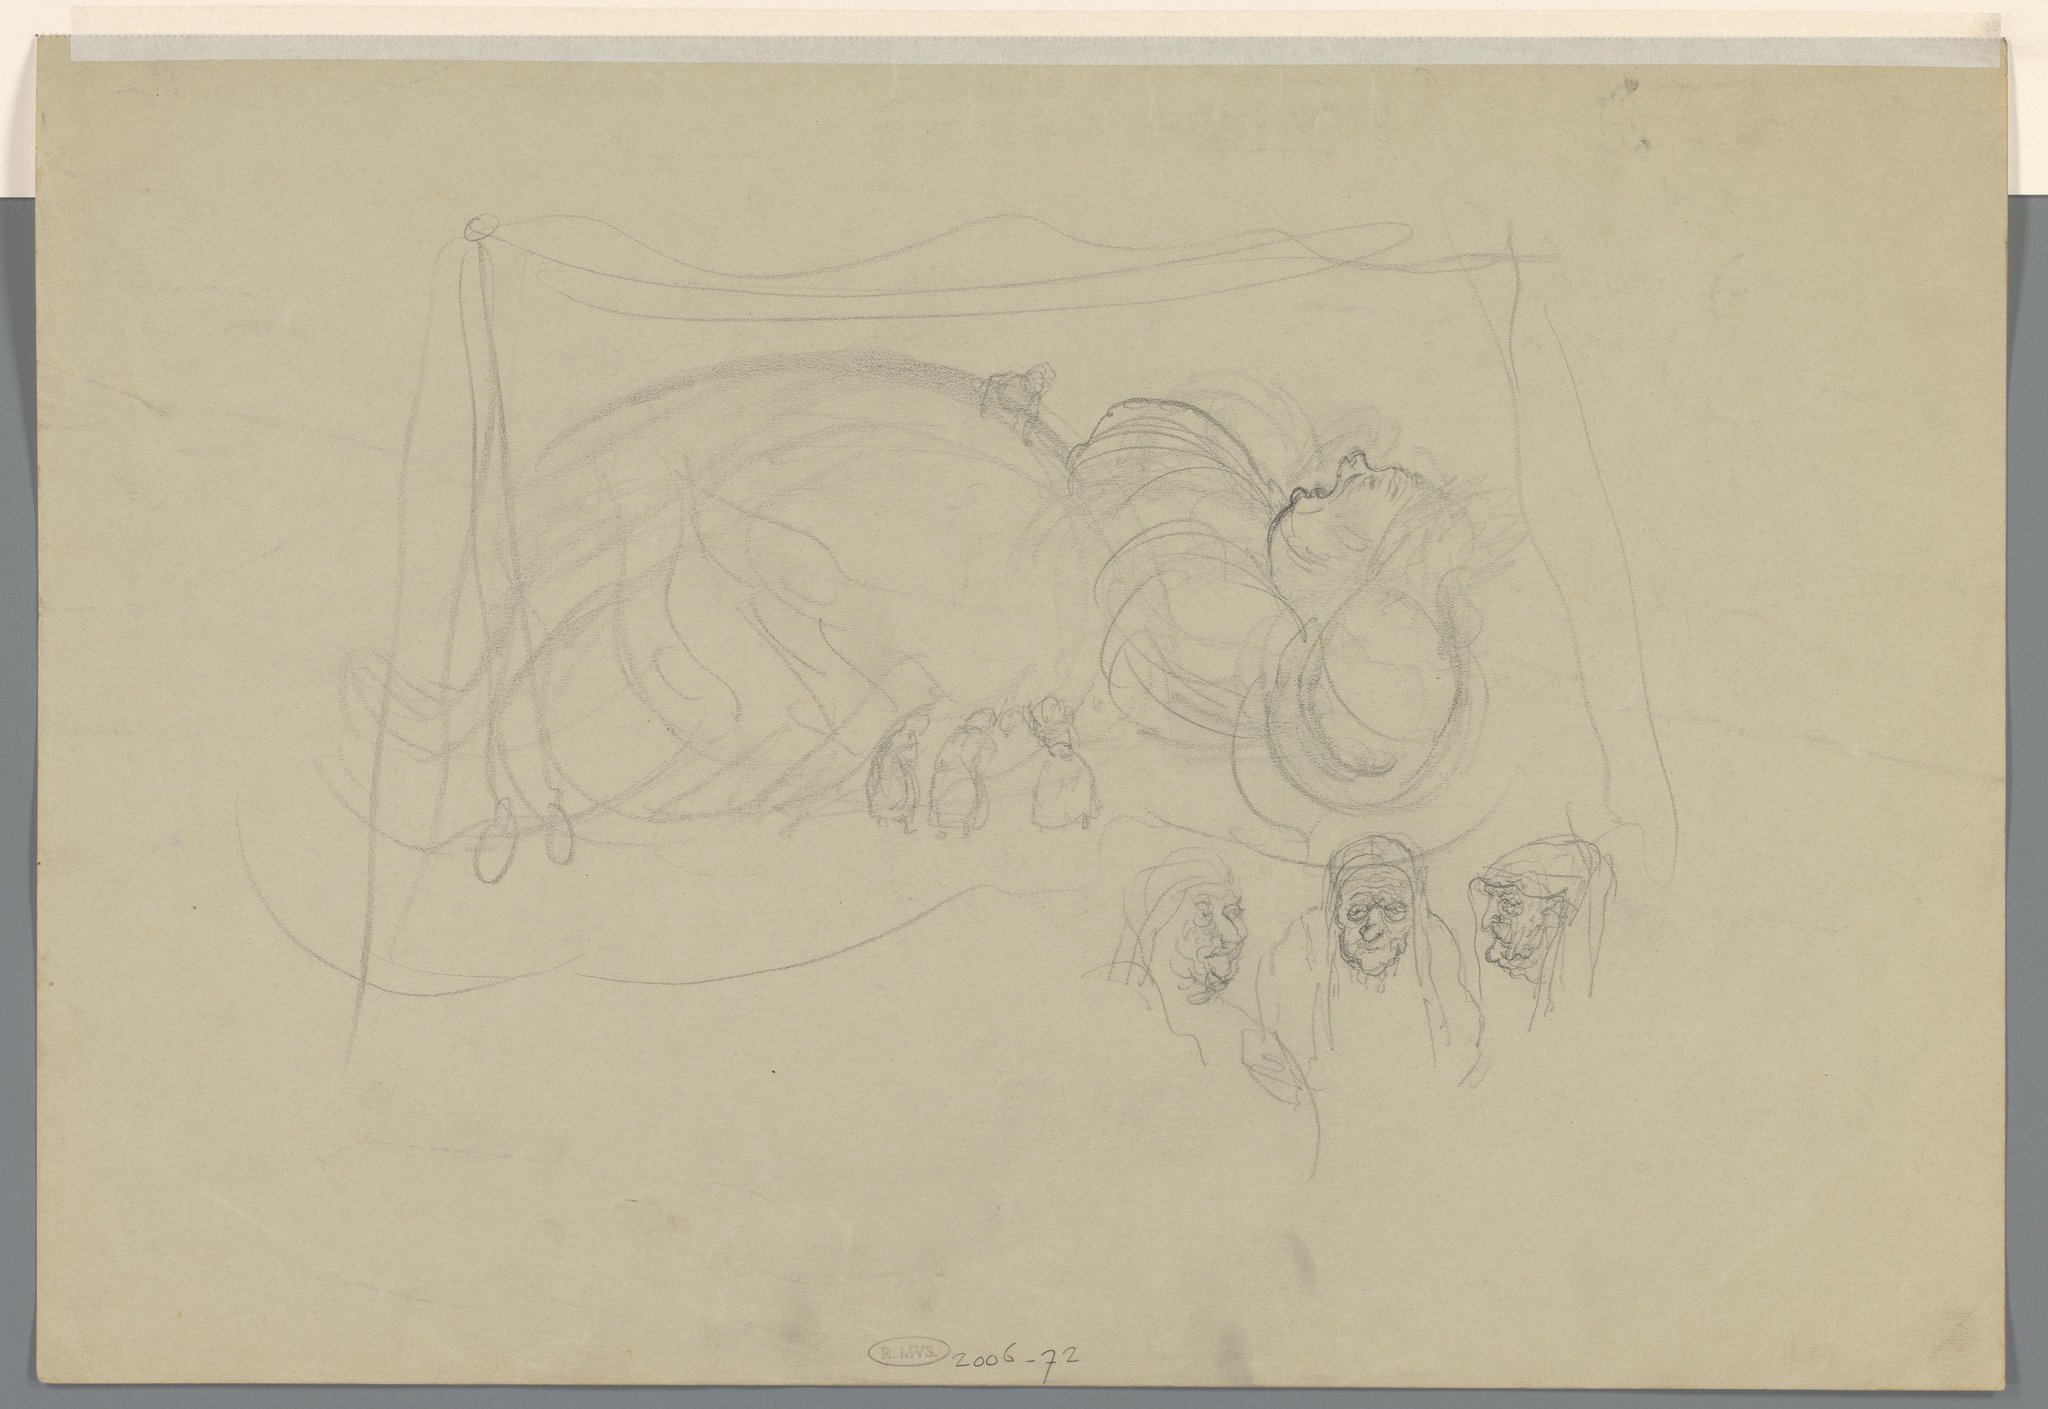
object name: drawing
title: Liggende reuzin met een open mond en drie hoofden van oude mensen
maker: henk henriët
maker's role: draughtsman, print maker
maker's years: 1903-1945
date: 1936-1940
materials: chalk, paper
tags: old man, lying figure - aa - female human figure, giants, colossi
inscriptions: collector's mark: Lugt 2228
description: Deze tekening is mogelijk een ontwerp voor een illustratie bij het boek 'Gargantua en Pantagruel' van François Rabelais.